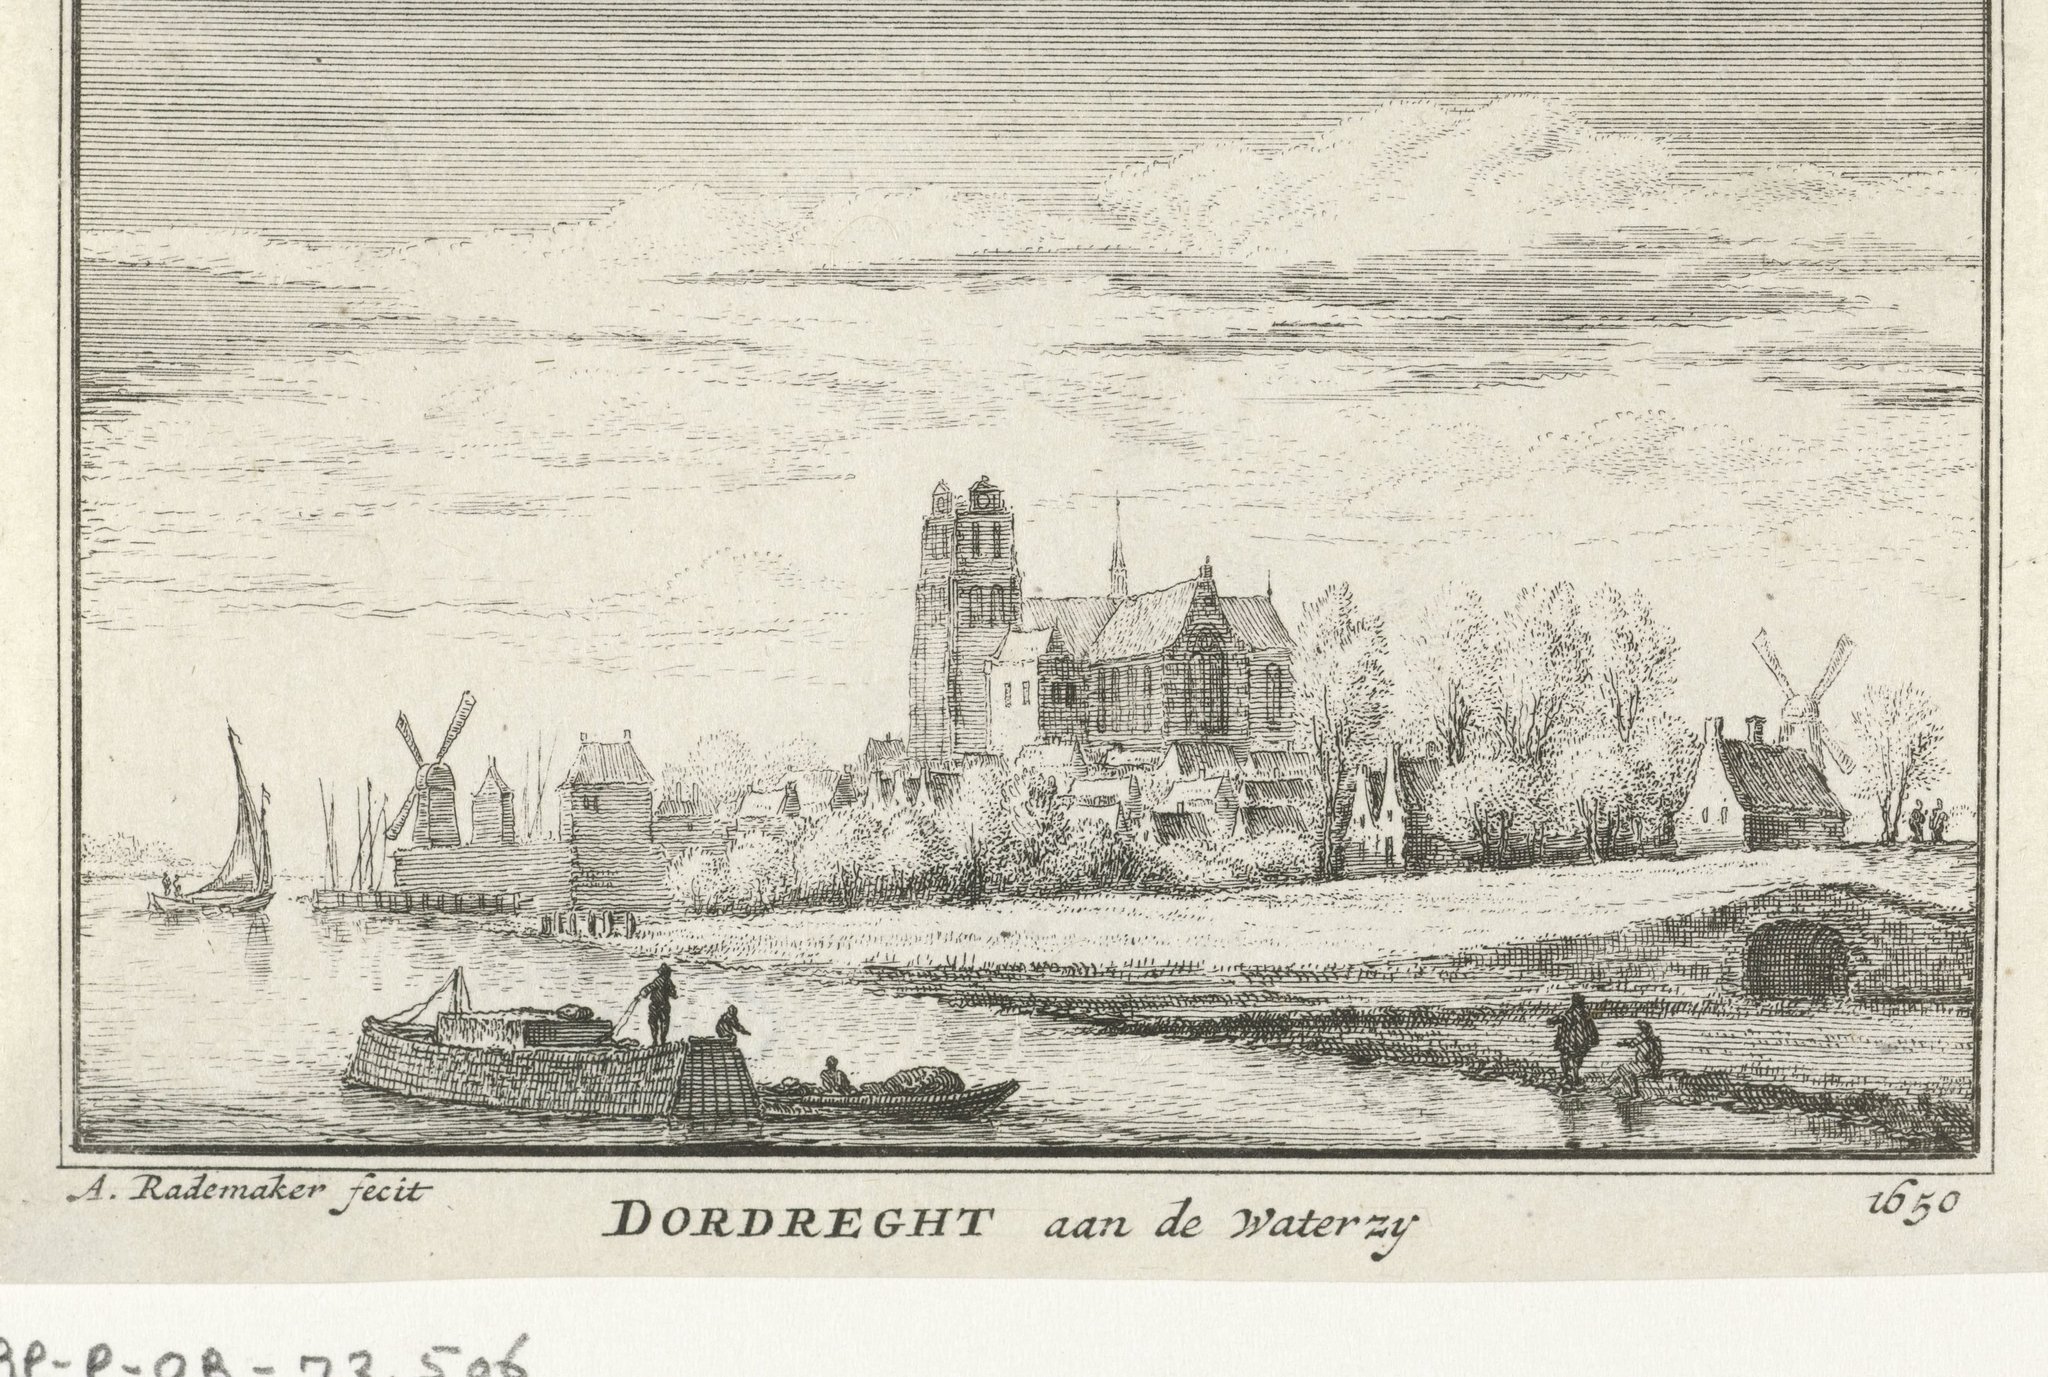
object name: print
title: Dordreght aan de waterzy 1650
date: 1727-1733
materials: paper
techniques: etching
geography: amsterdam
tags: machine driven by wind, sailing-ship, sailing-boat, church (exterior), rowing-boat, canoe, etc., prospect of city, town panorama, silhouette of city, dordrecht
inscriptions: collector's mark: Lugt 2228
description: Illustratie uit: Abraham Rademaker, Matthaeus Brouërius van Niedek, Isaac Le Long, Kabinet van Nederlandsche en Kleefsche outheden en (...) voorname stads- en landgebouwen, Willem Barents en Antoni Schoonenburg: Amsterdam, 1727-1733, ill. nr. 153.